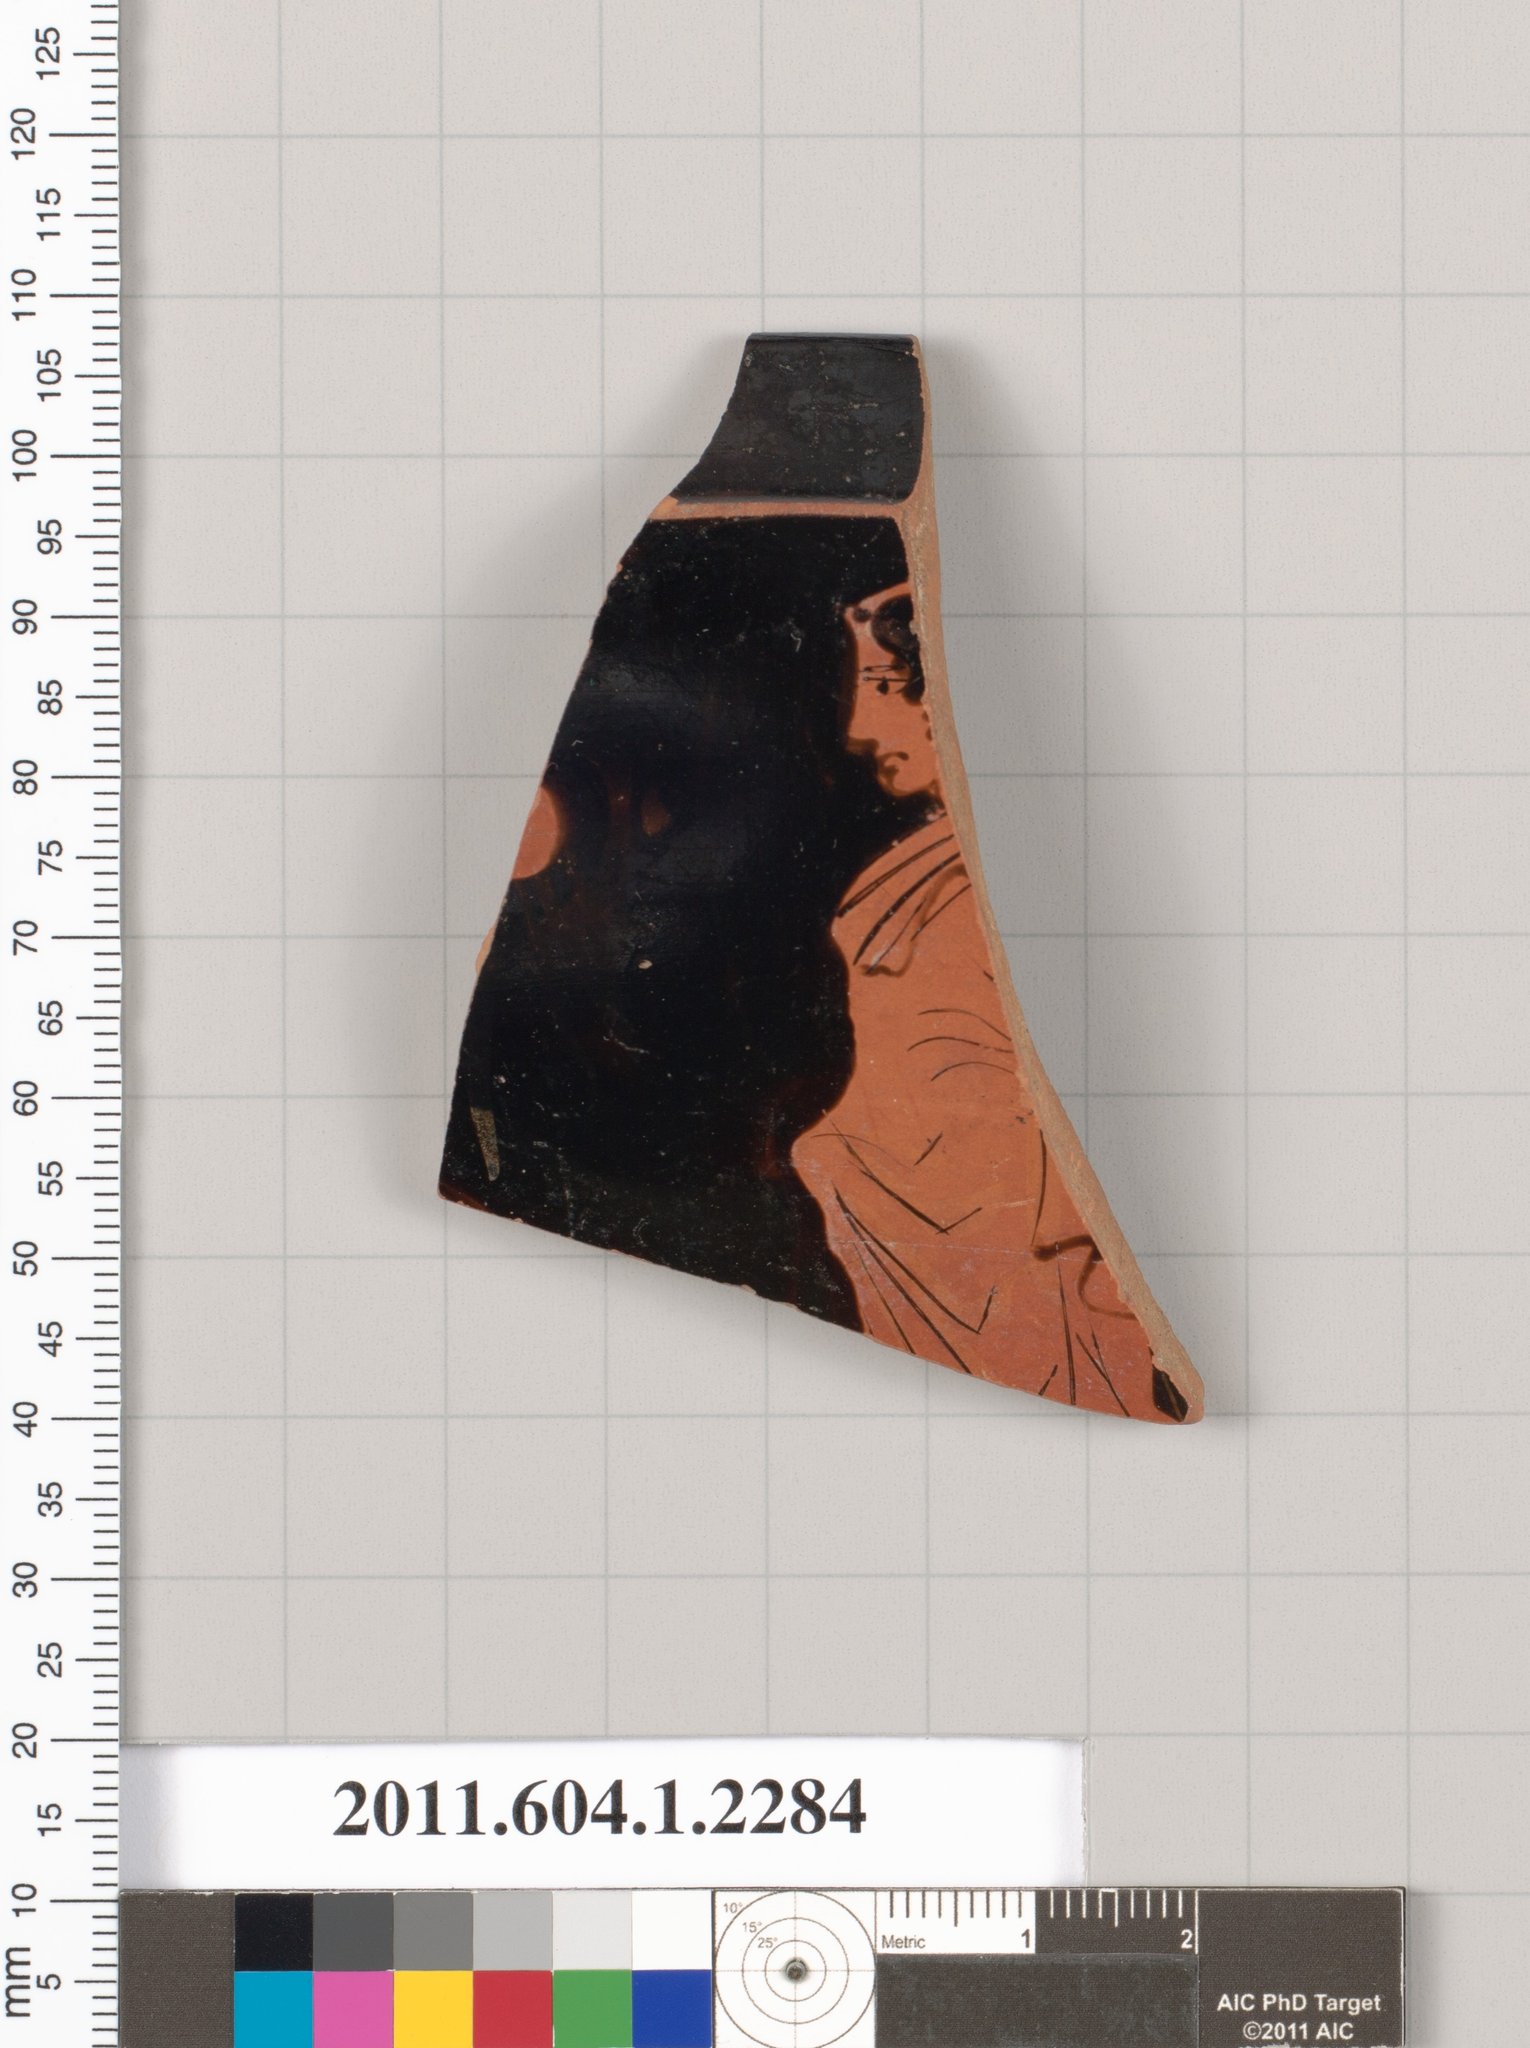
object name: kylix fragment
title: Terracotta rim fragment of a kylix (drinking cup)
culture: greek, attic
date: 460-450 BCE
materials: terracotta